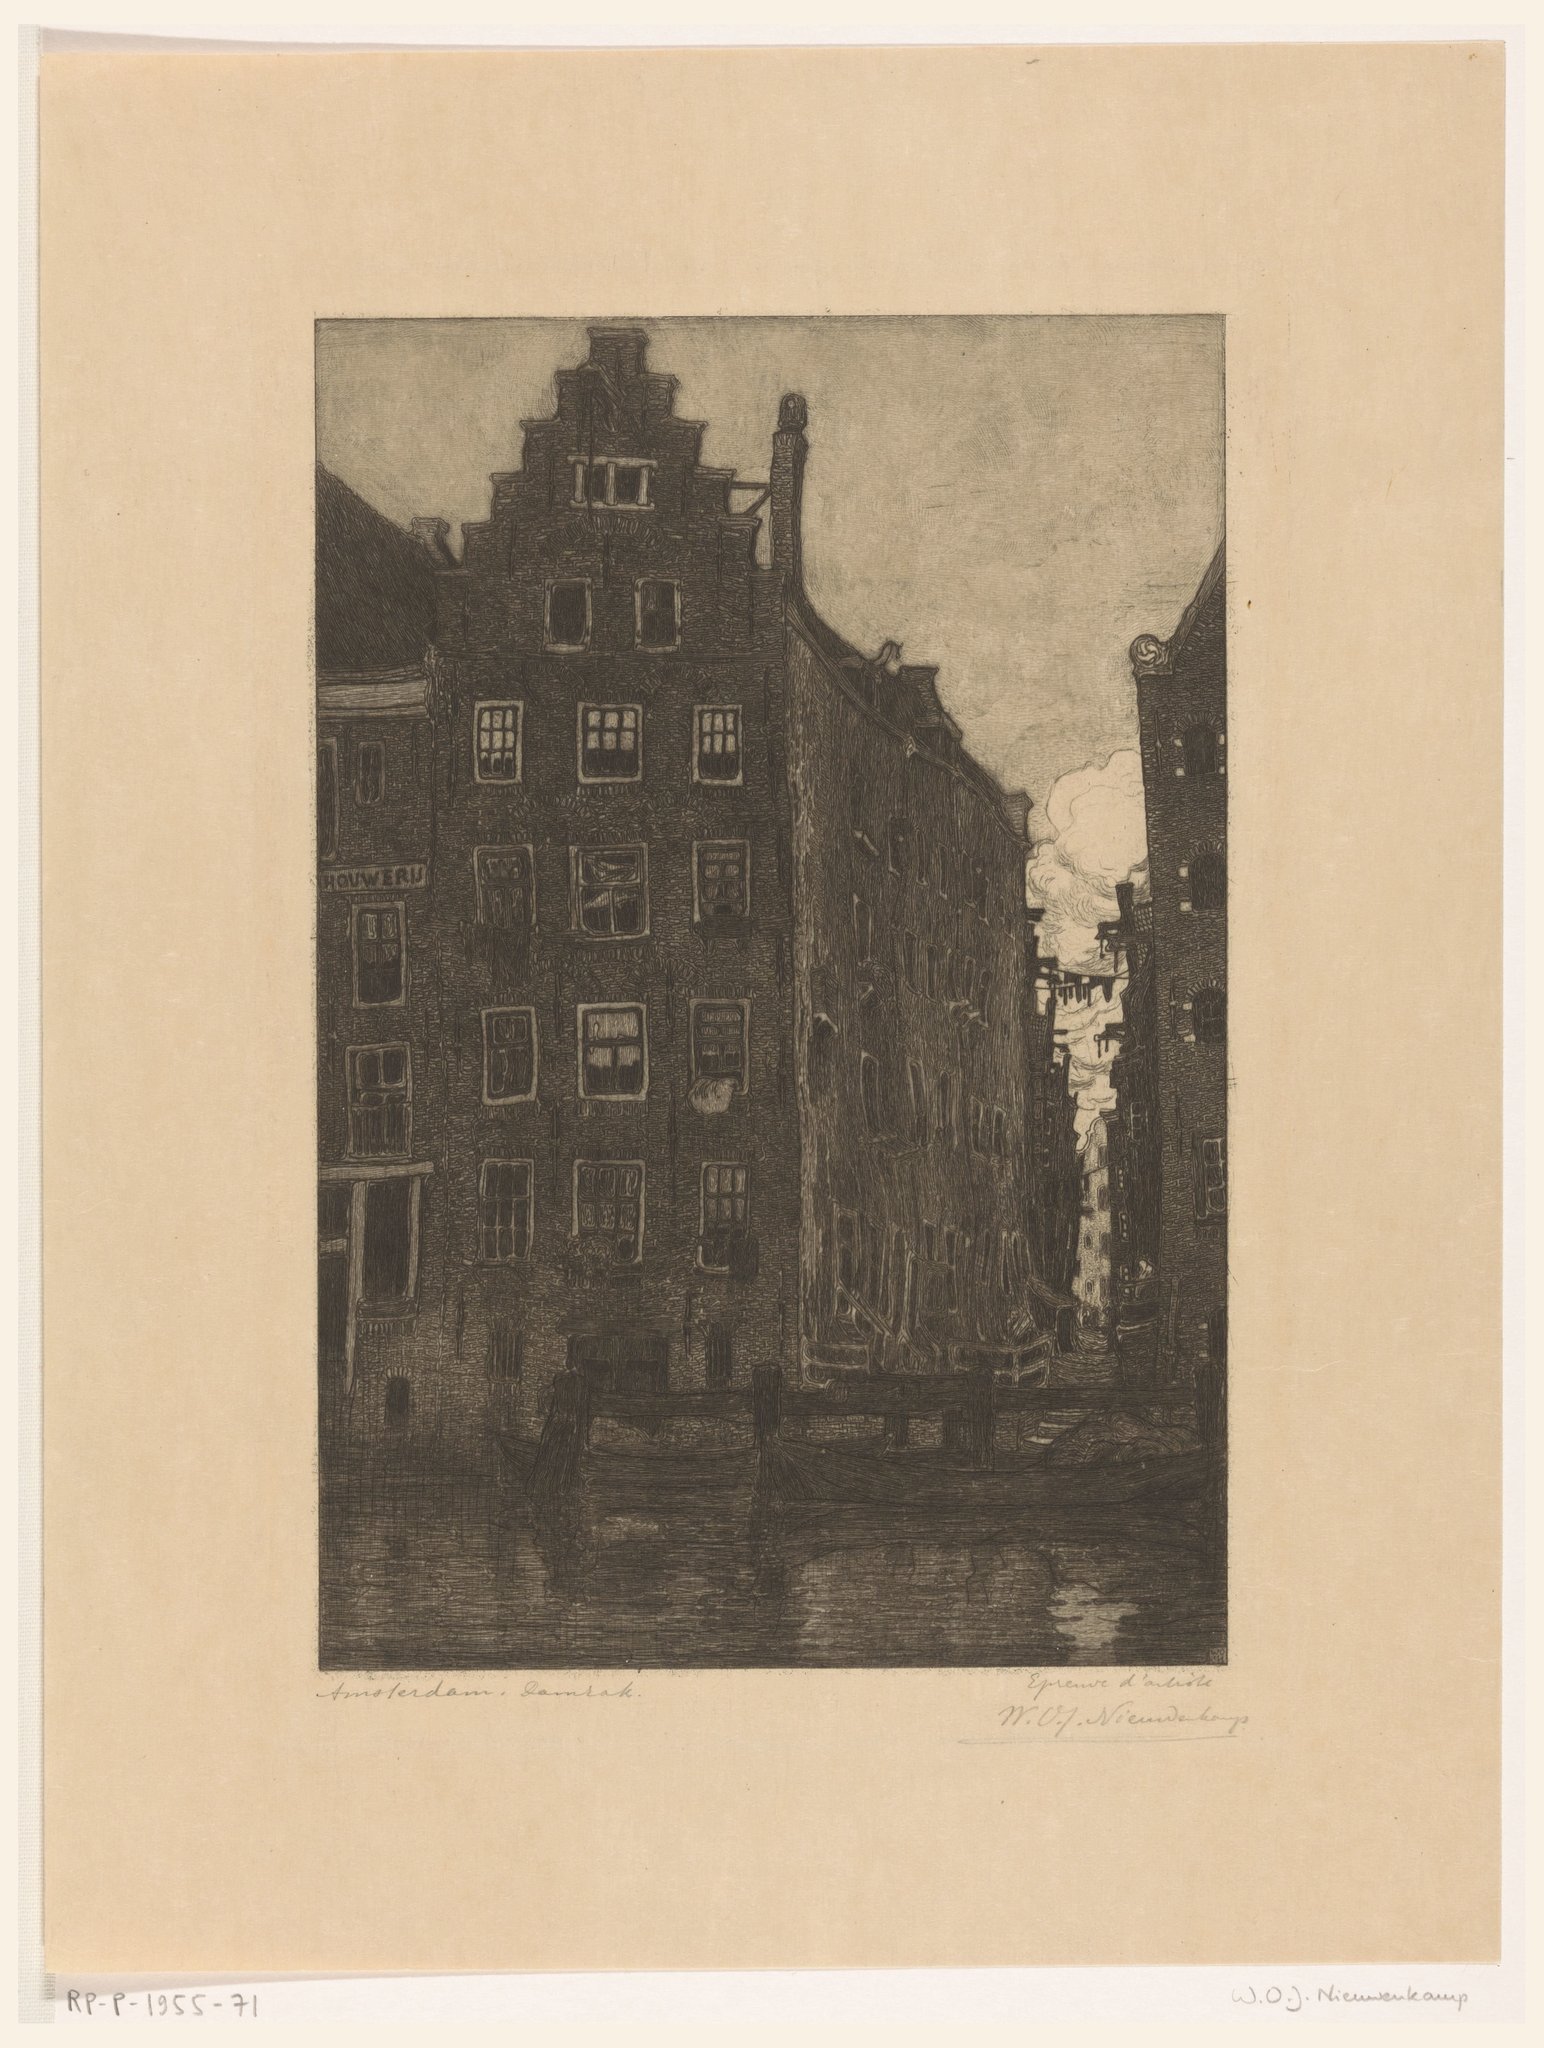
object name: print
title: Huizen aan het Damrak in Amsterdam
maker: wijnand otto jan nieuwenkamp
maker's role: draughtsman, print maker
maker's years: 1874-1950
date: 1897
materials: paper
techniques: etching, intaglio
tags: canals, waters (in city), lane, alley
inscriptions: collector's mark: Lugt 2228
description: De achtergevels van huizen aan het ongedempte gedeelte van het Damrak in Amsterdam. Rechts de Guldehandsteeg. Op de voorgrond schuiten bij een houten steiger.